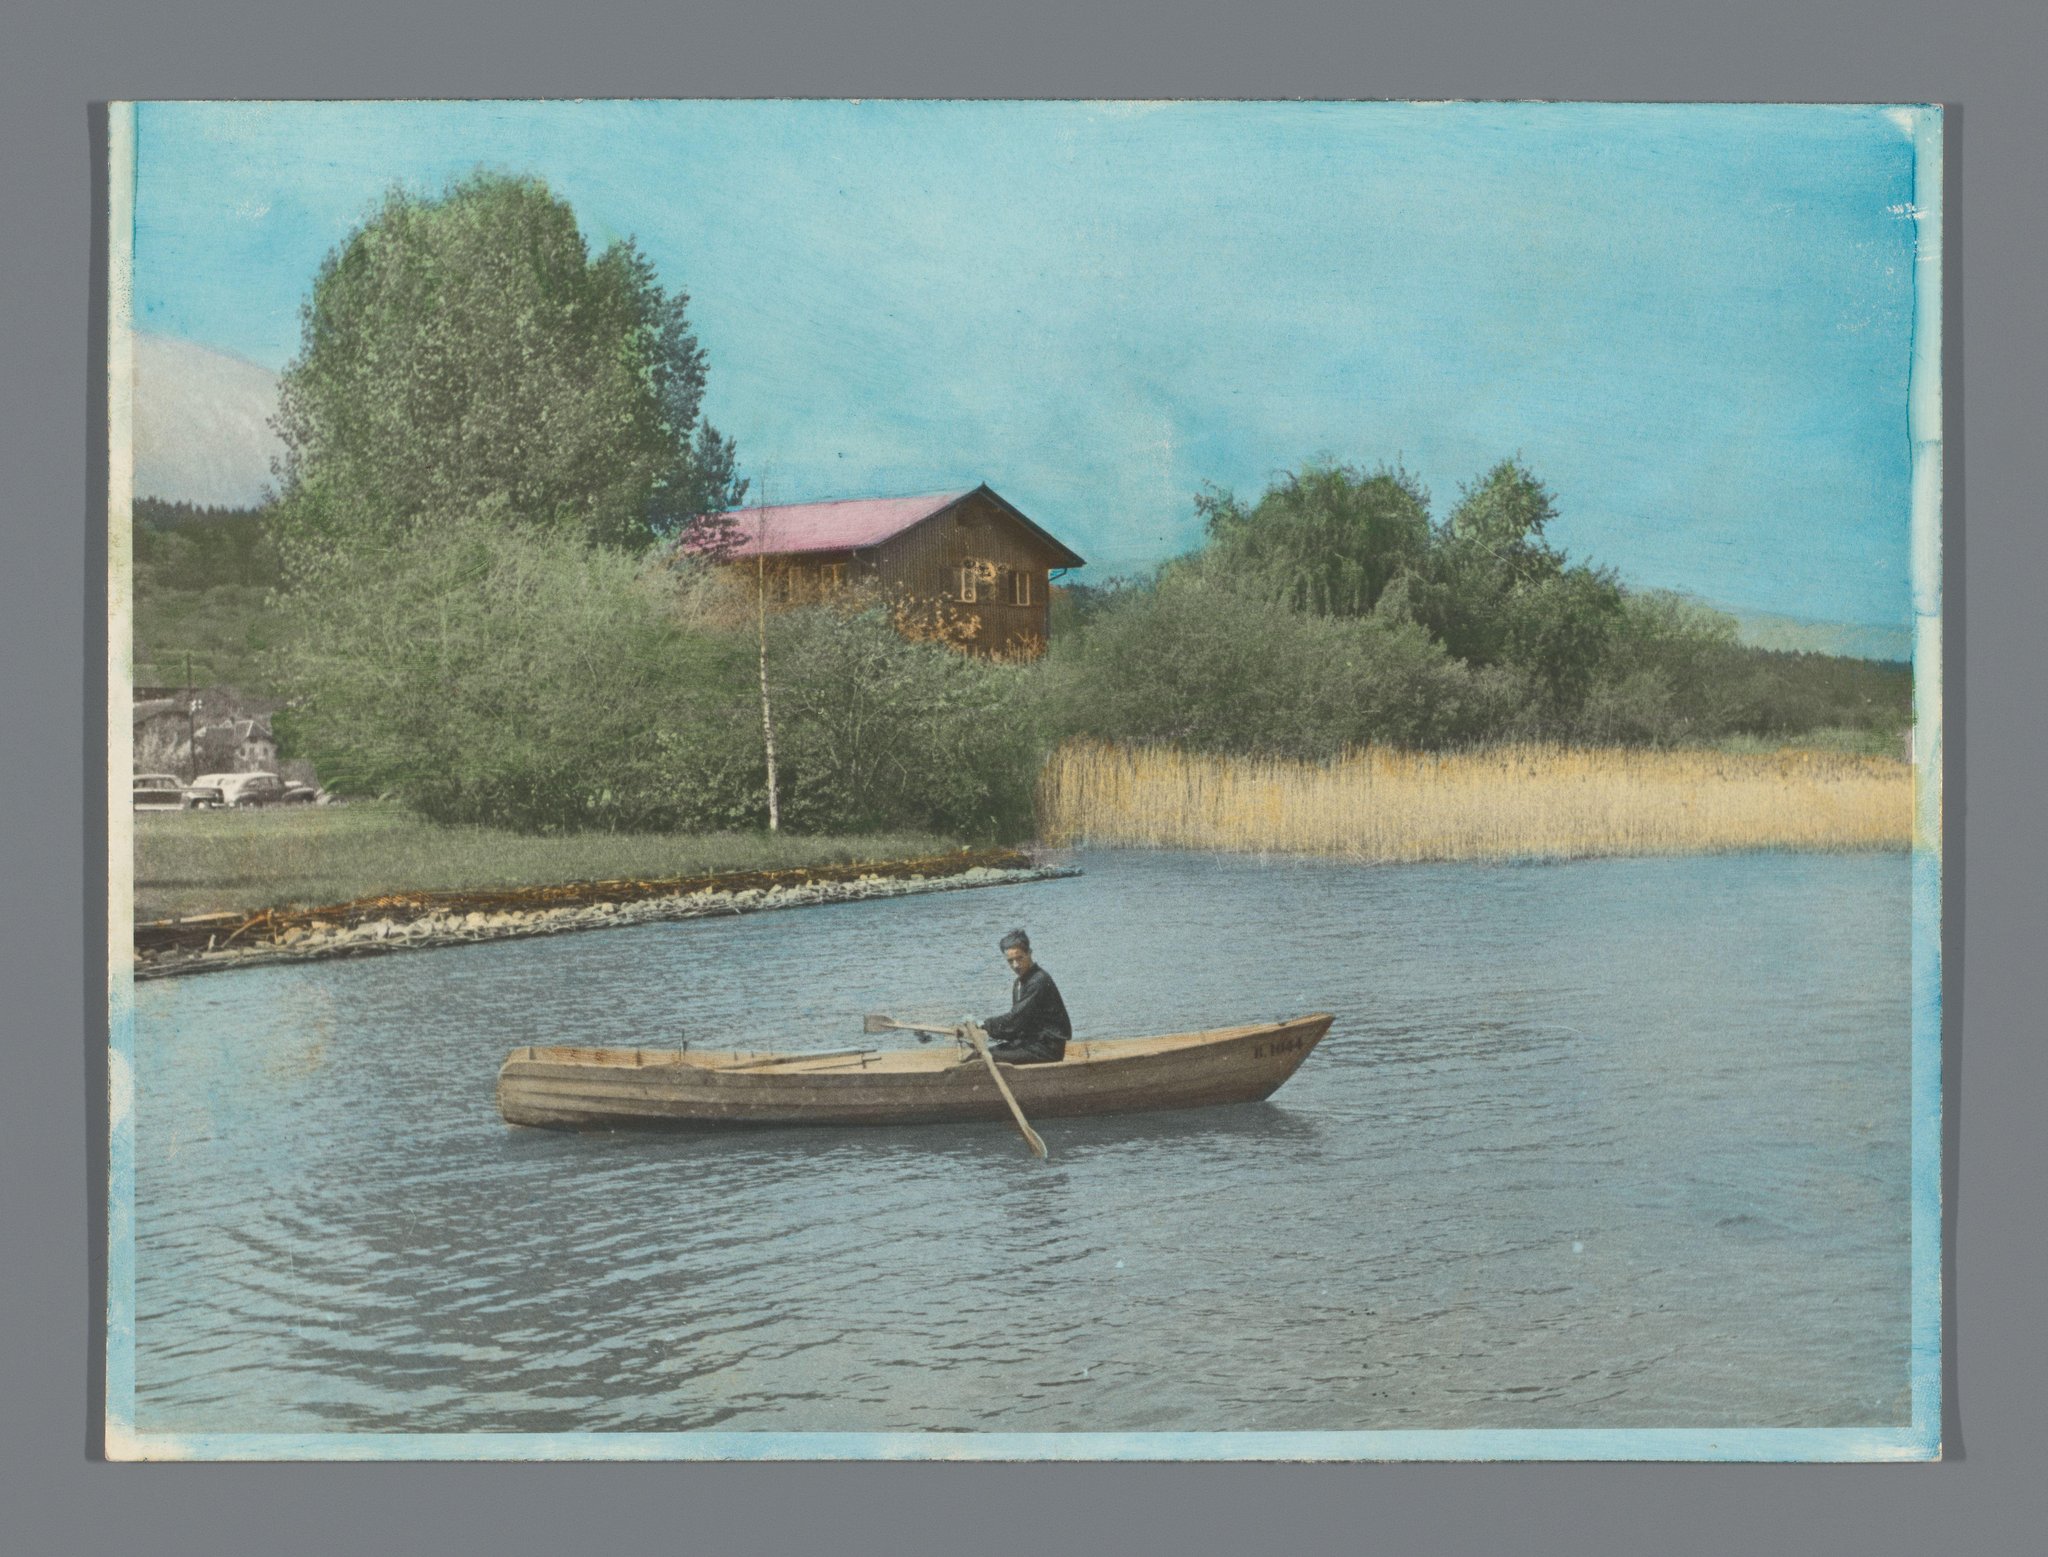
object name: photograph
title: Landschap in kleur met een jonge man in een roeiboot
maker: Anonymous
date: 1900-1920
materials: photographic support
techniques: gelatin silver print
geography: united states